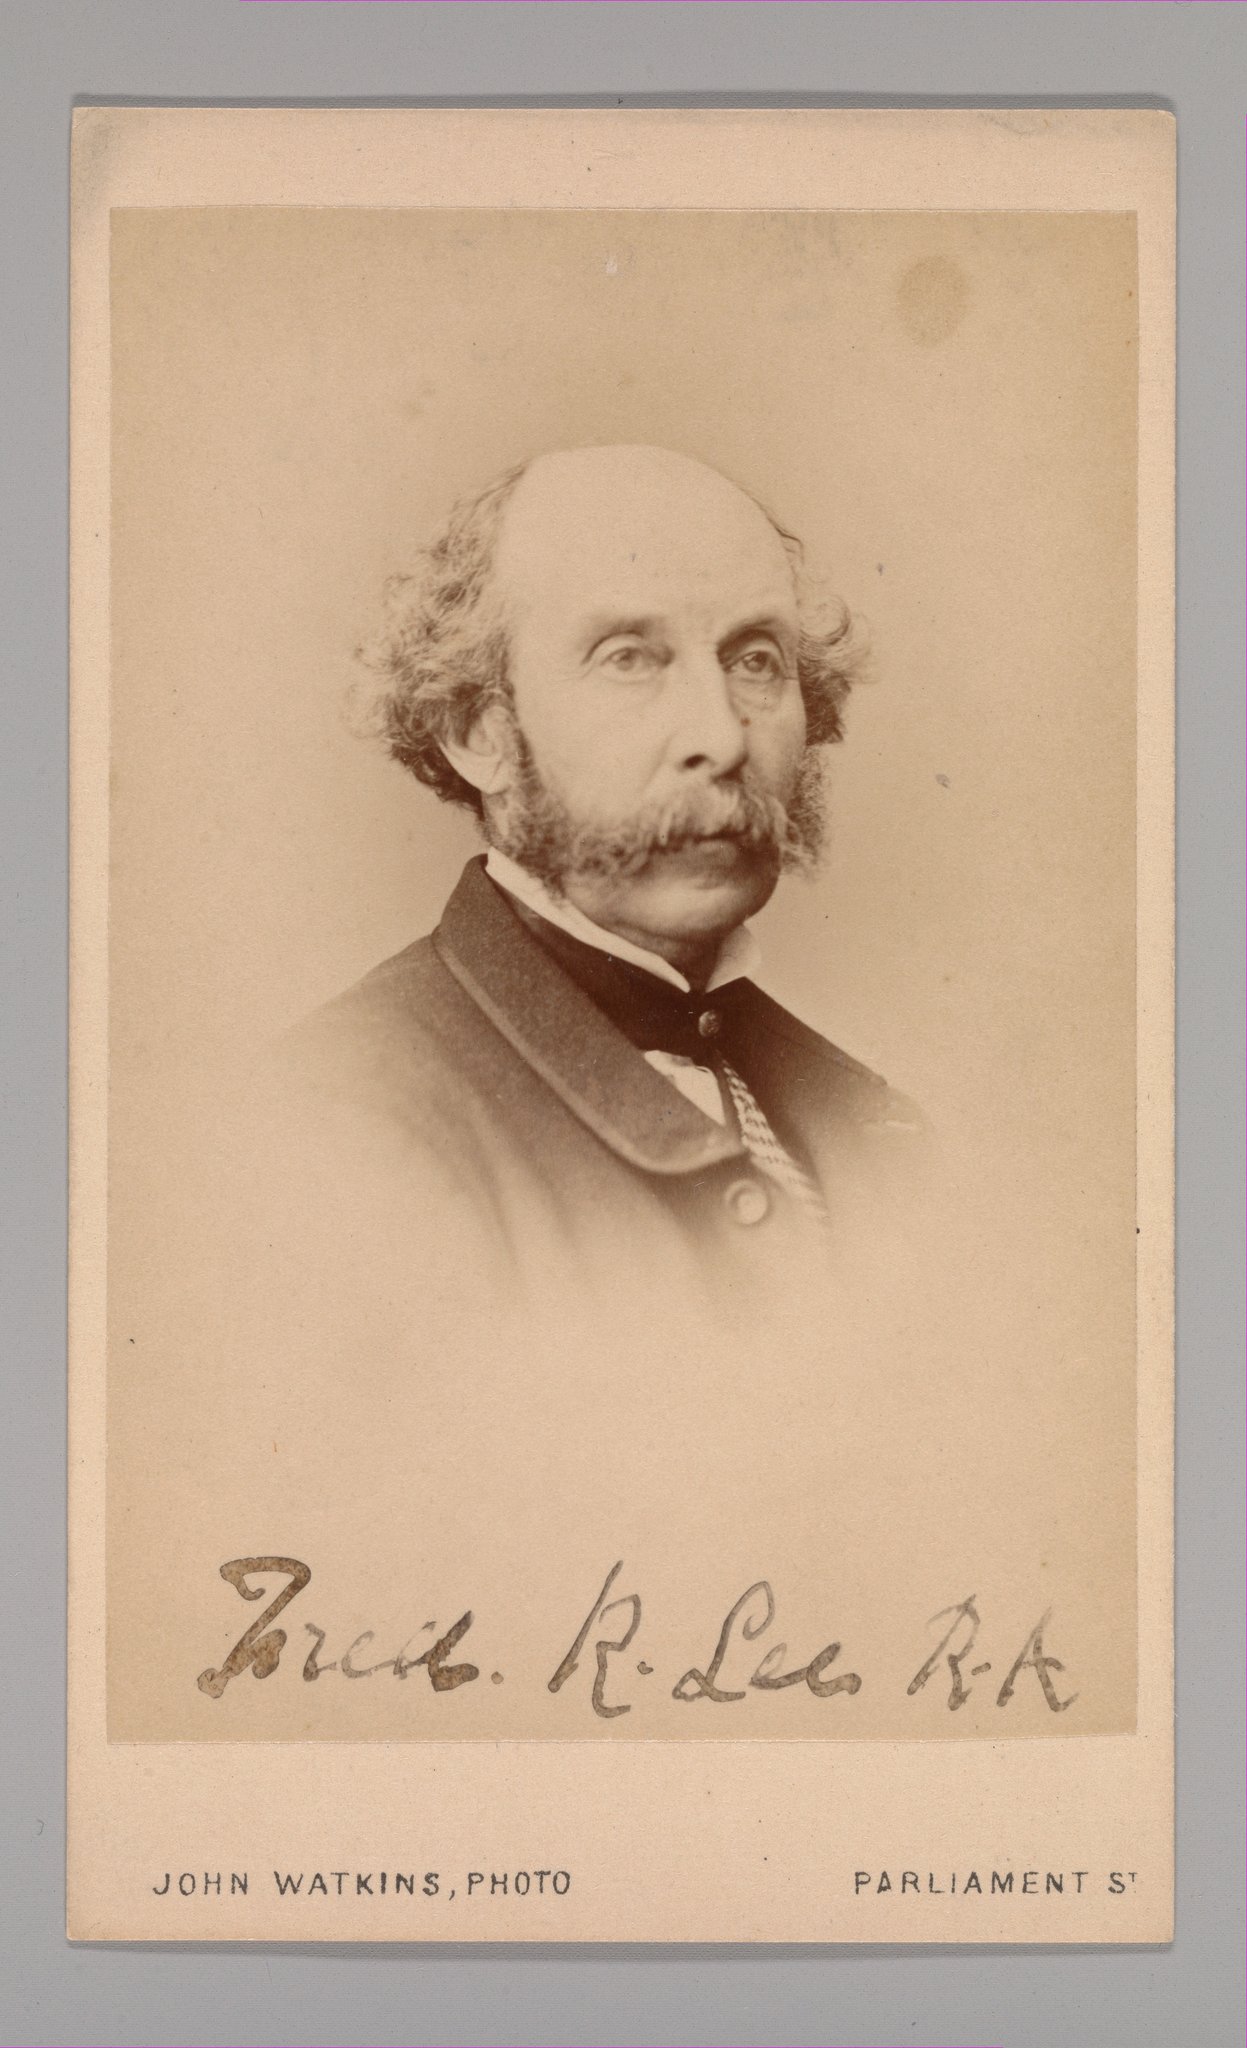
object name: carte de visite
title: [Frederick Richard Lee]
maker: john and charles watkins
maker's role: photography studio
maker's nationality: british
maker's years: 1840-1875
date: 1860-1869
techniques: albumen silver print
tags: men,portraits